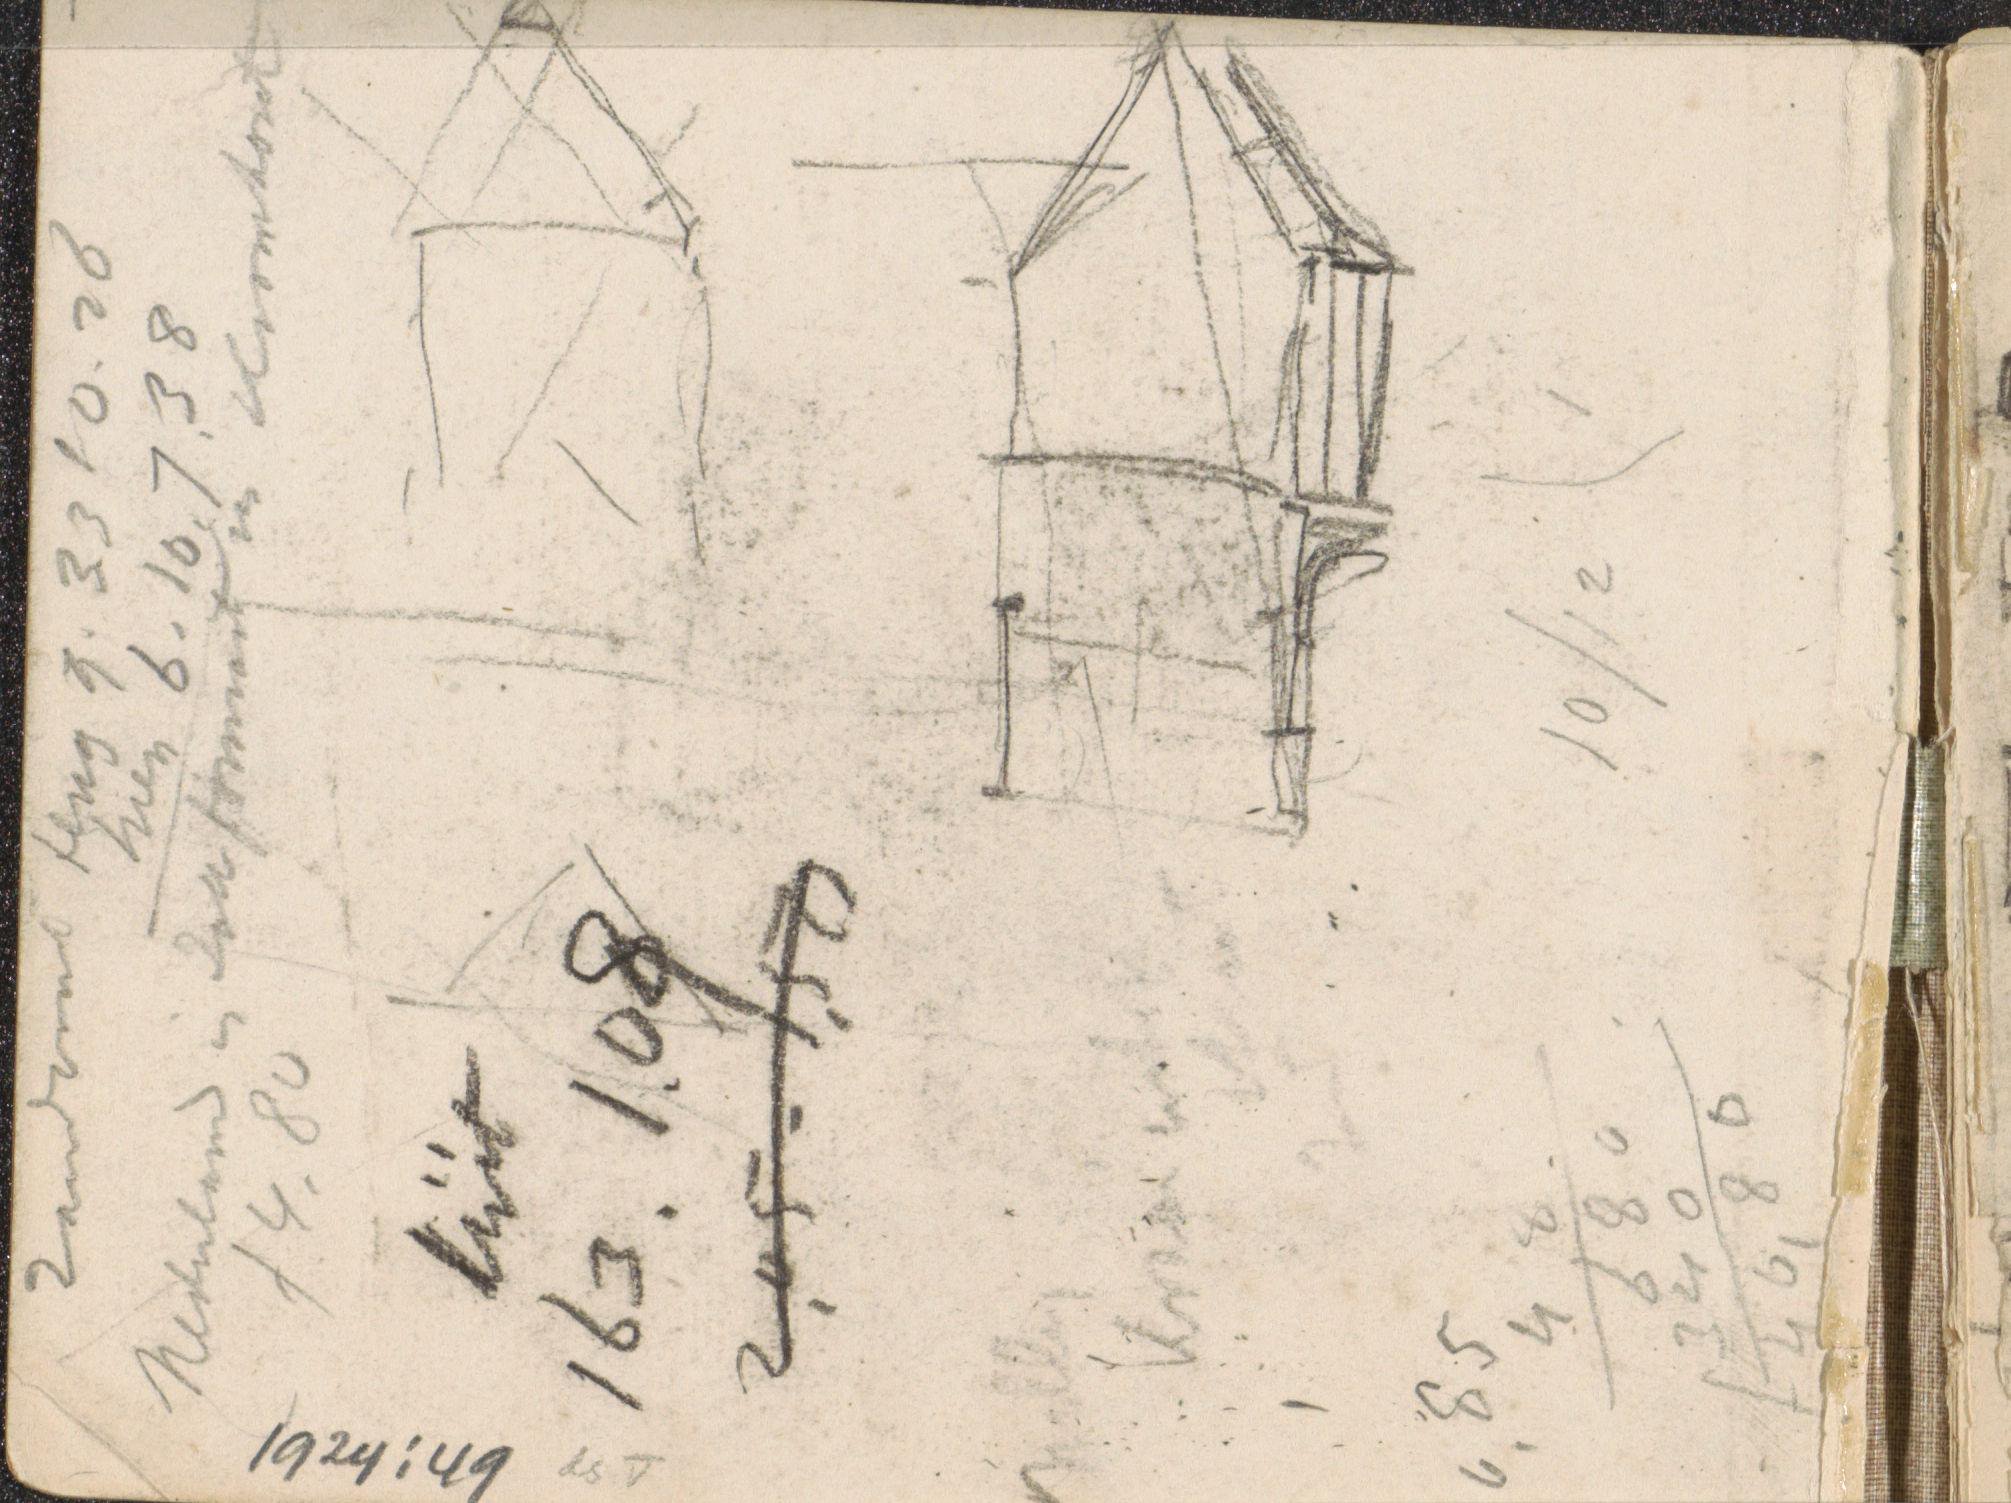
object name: endleaf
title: Gebouwen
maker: george hendrik breitner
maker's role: draughtsman, painter, print maker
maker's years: 1857-1923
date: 1885-1898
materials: chalk, paper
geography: amsterdam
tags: architecture, civic architecture; edifices; dwellings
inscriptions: annotation: ‘Zandvoort terug 9. 33 10. 26/ heen 6. 10. 7. 38/ Nederland in zakformaat in Kromhout/ [...]’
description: Pagina 1, voorste schutblad, uit een schetsboek met 32 bladen.